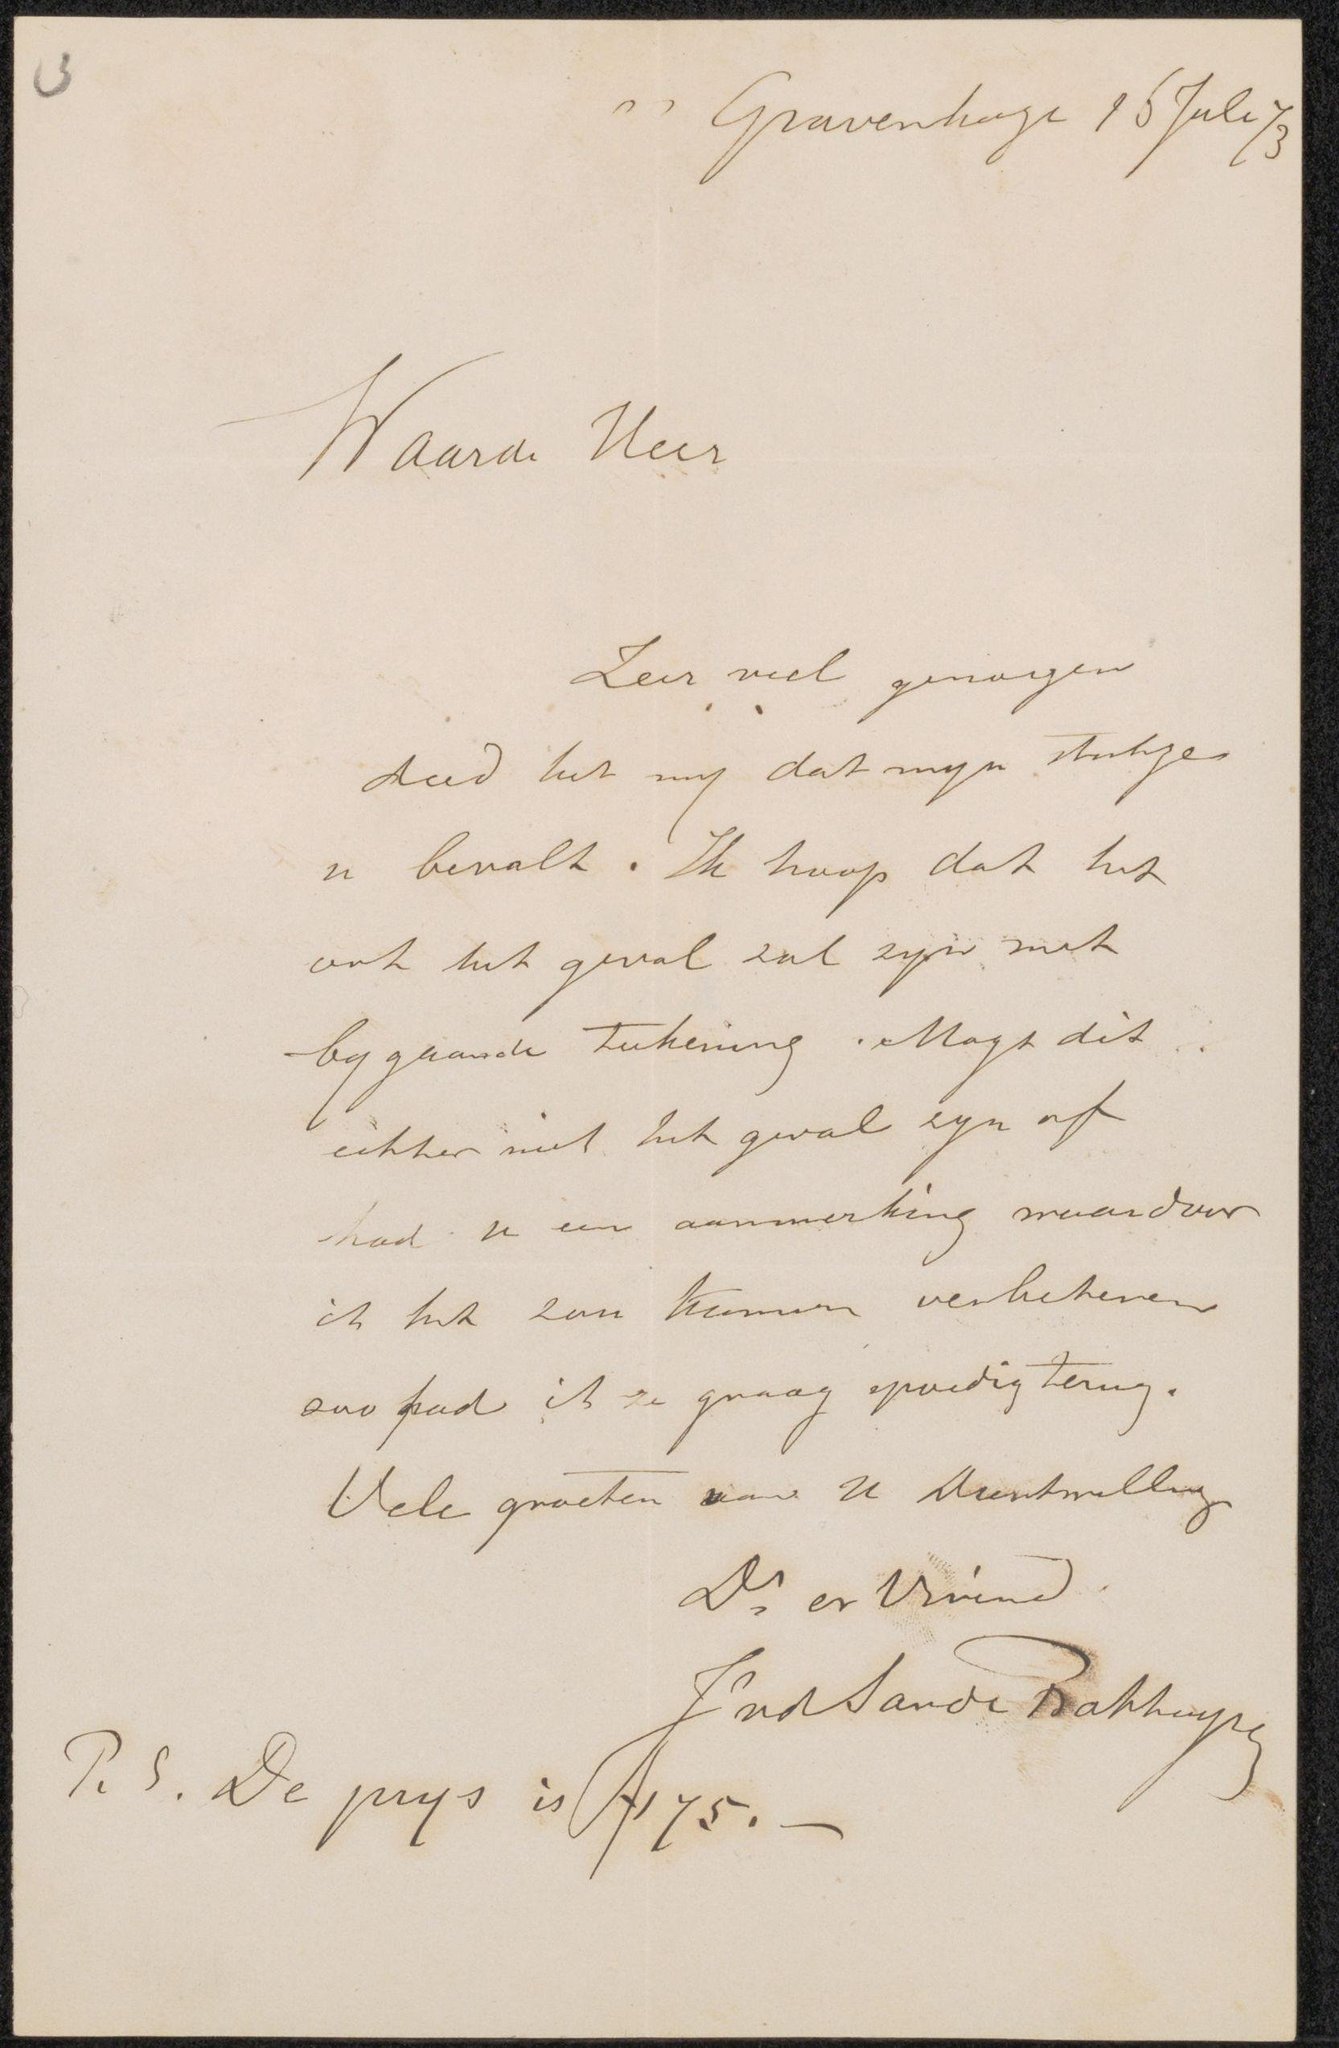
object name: letter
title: Brief aan Frans Buffa en Zonen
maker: julius jacobus van de sande bakhuyzen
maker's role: draughtsman, painter, print maker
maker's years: 1835-1925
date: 1873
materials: ink, paper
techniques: pen, writing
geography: the hague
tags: publisher, drawing, money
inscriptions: collector's mark: Lugt 2233